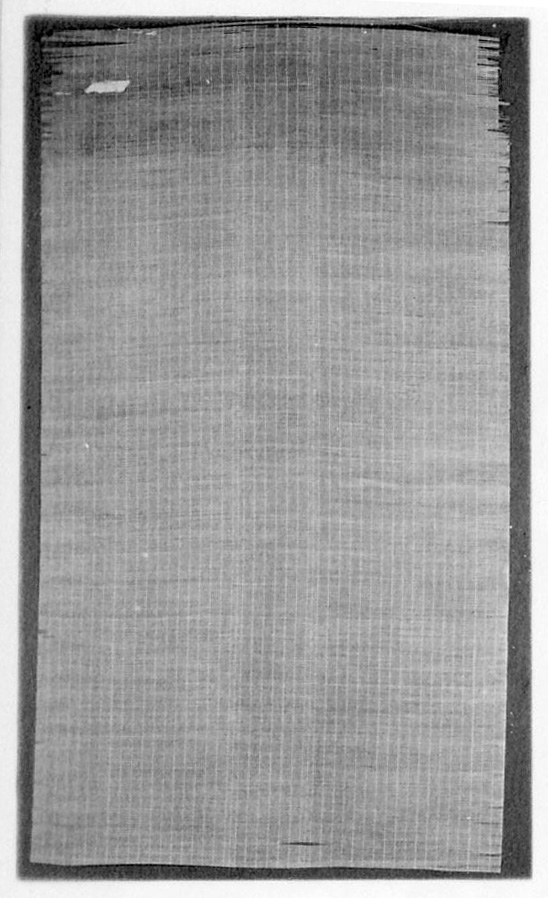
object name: blind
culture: chinese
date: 1701-1800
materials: bamboo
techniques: lacquer